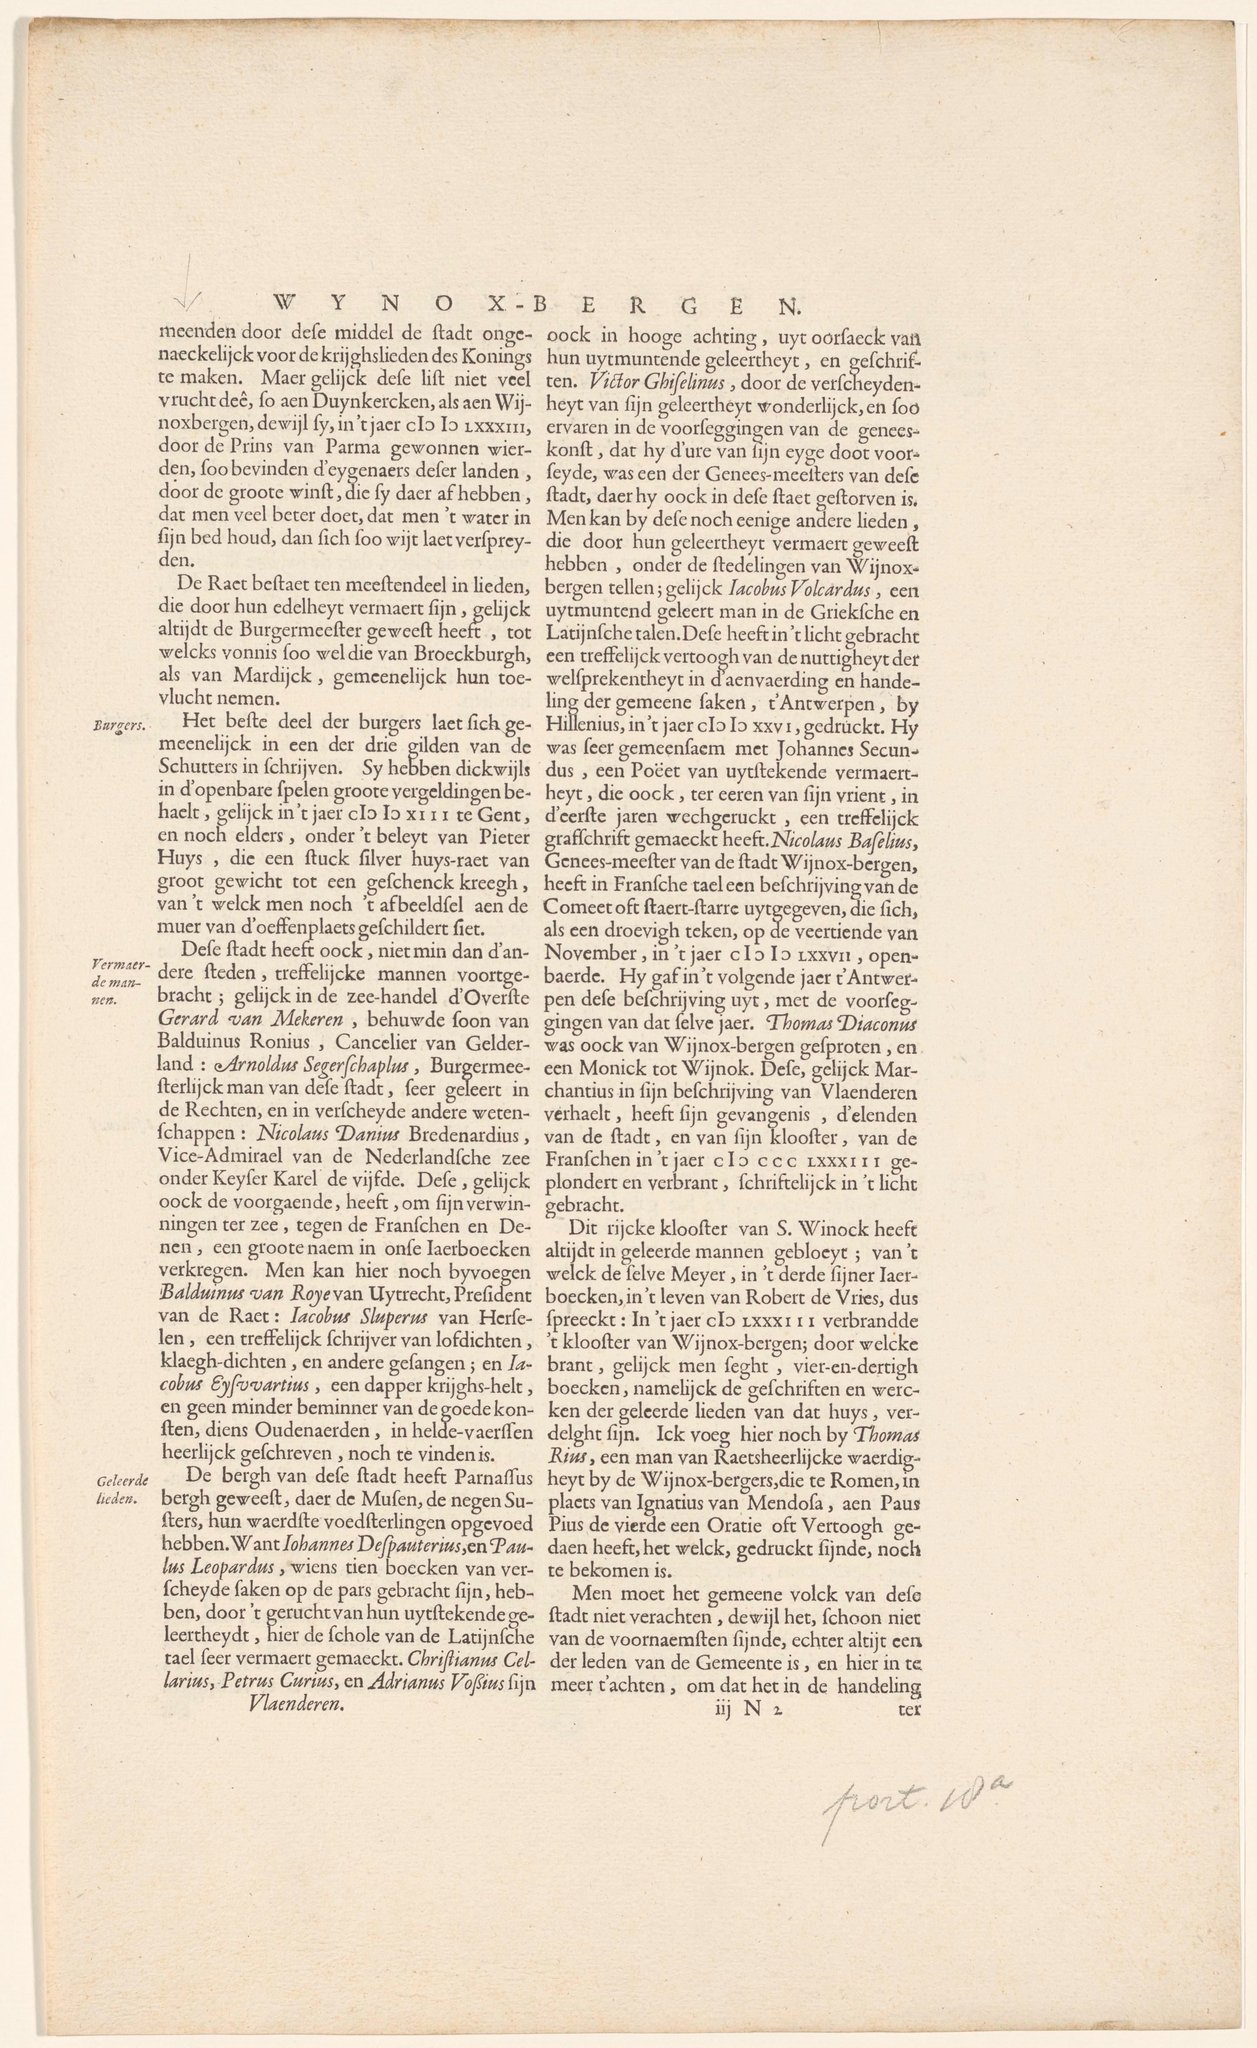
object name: text sheet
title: Wynox-Bergen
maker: johannes willemszoon blaeu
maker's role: printer, publisher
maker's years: 1596-1673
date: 1652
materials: paper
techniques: letterpress printing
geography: amsterdam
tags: sint-winoksbergen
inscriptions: collector's mark: Lugt 2228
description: Tekst gebruikt in: Blaeu, Johannes Willemszoon. Toonneel der steden van de Vereenighde Nederlanden. 2 delen. Amsterdam: Johannes Willemszoon Blaeu, 1652, dl. 2. Zie ook: RP-P-AO-18-121-1.